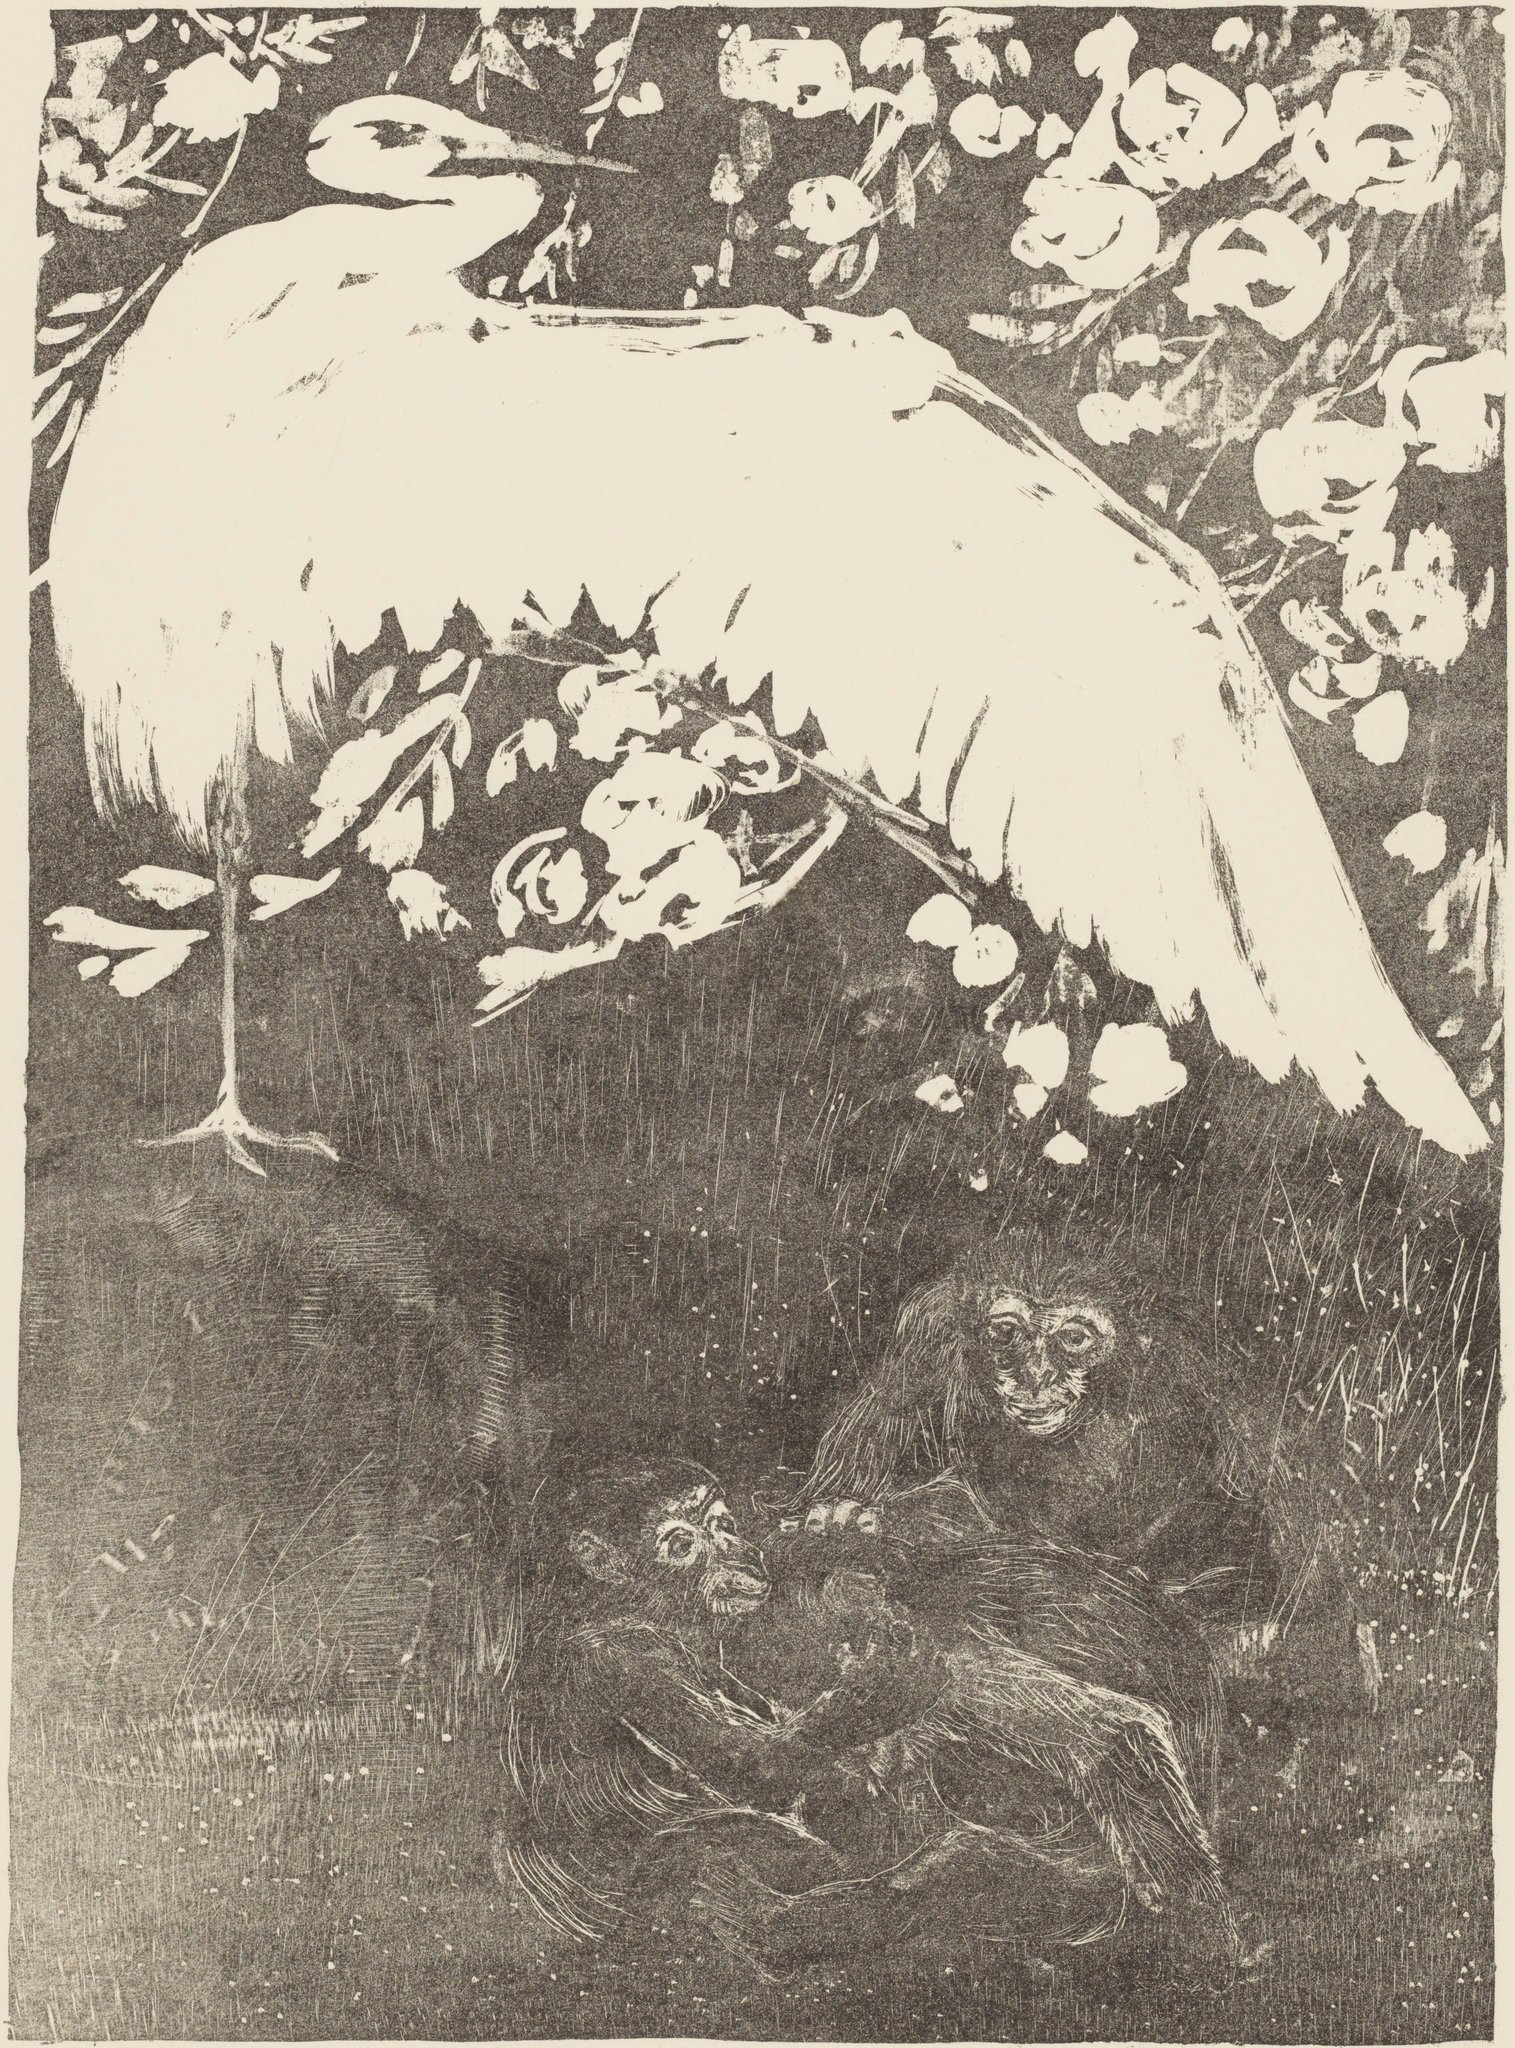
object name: print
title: Reiger met drie apen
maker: theo van hoytema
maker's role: draughtsman, painter, print maker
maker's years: 1863-1917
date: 1905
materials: paper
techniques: lithograph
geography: london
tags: monkeys, apes, shore-birds and wading-birds: heron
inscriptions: collector's mark: Lugt 2233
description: Een reiger met uitgestoken vleugel waaronder drie apen spelen.